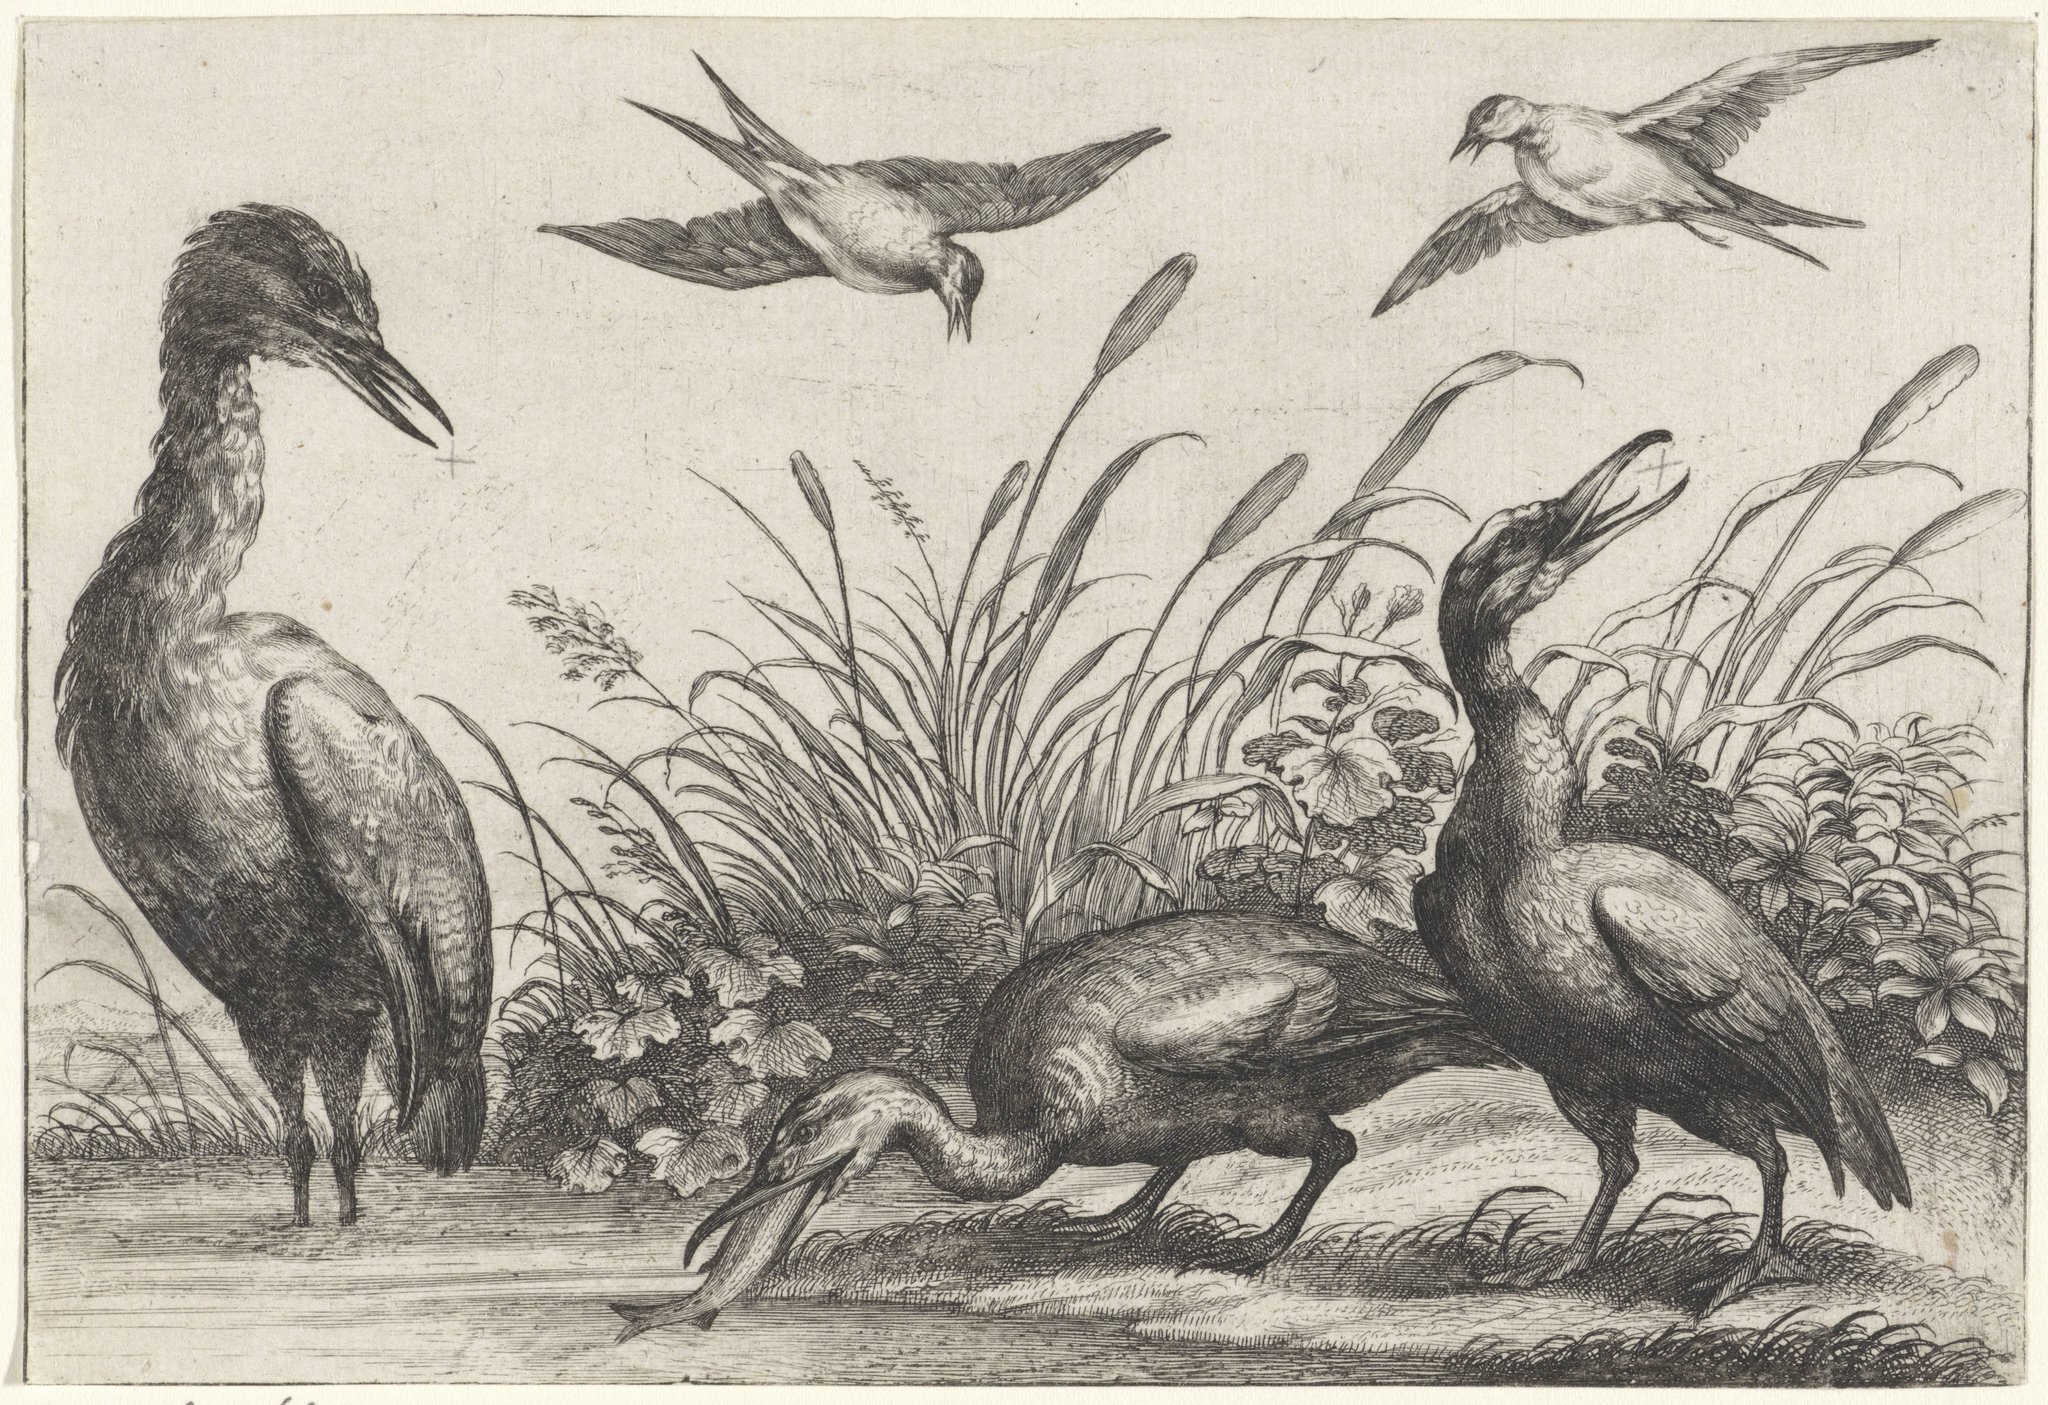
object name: print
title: Reigers en zwaluwen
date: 1654-1750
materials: paper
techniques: etching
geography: london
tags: shore-birds and wading-birds: heron, song-birds: swallow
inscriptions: collector's mark: Lugt 240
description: Vgl. serie "Verschillende vogels", door Wenceslaus Hollar. Specifiek: NHG 1338.